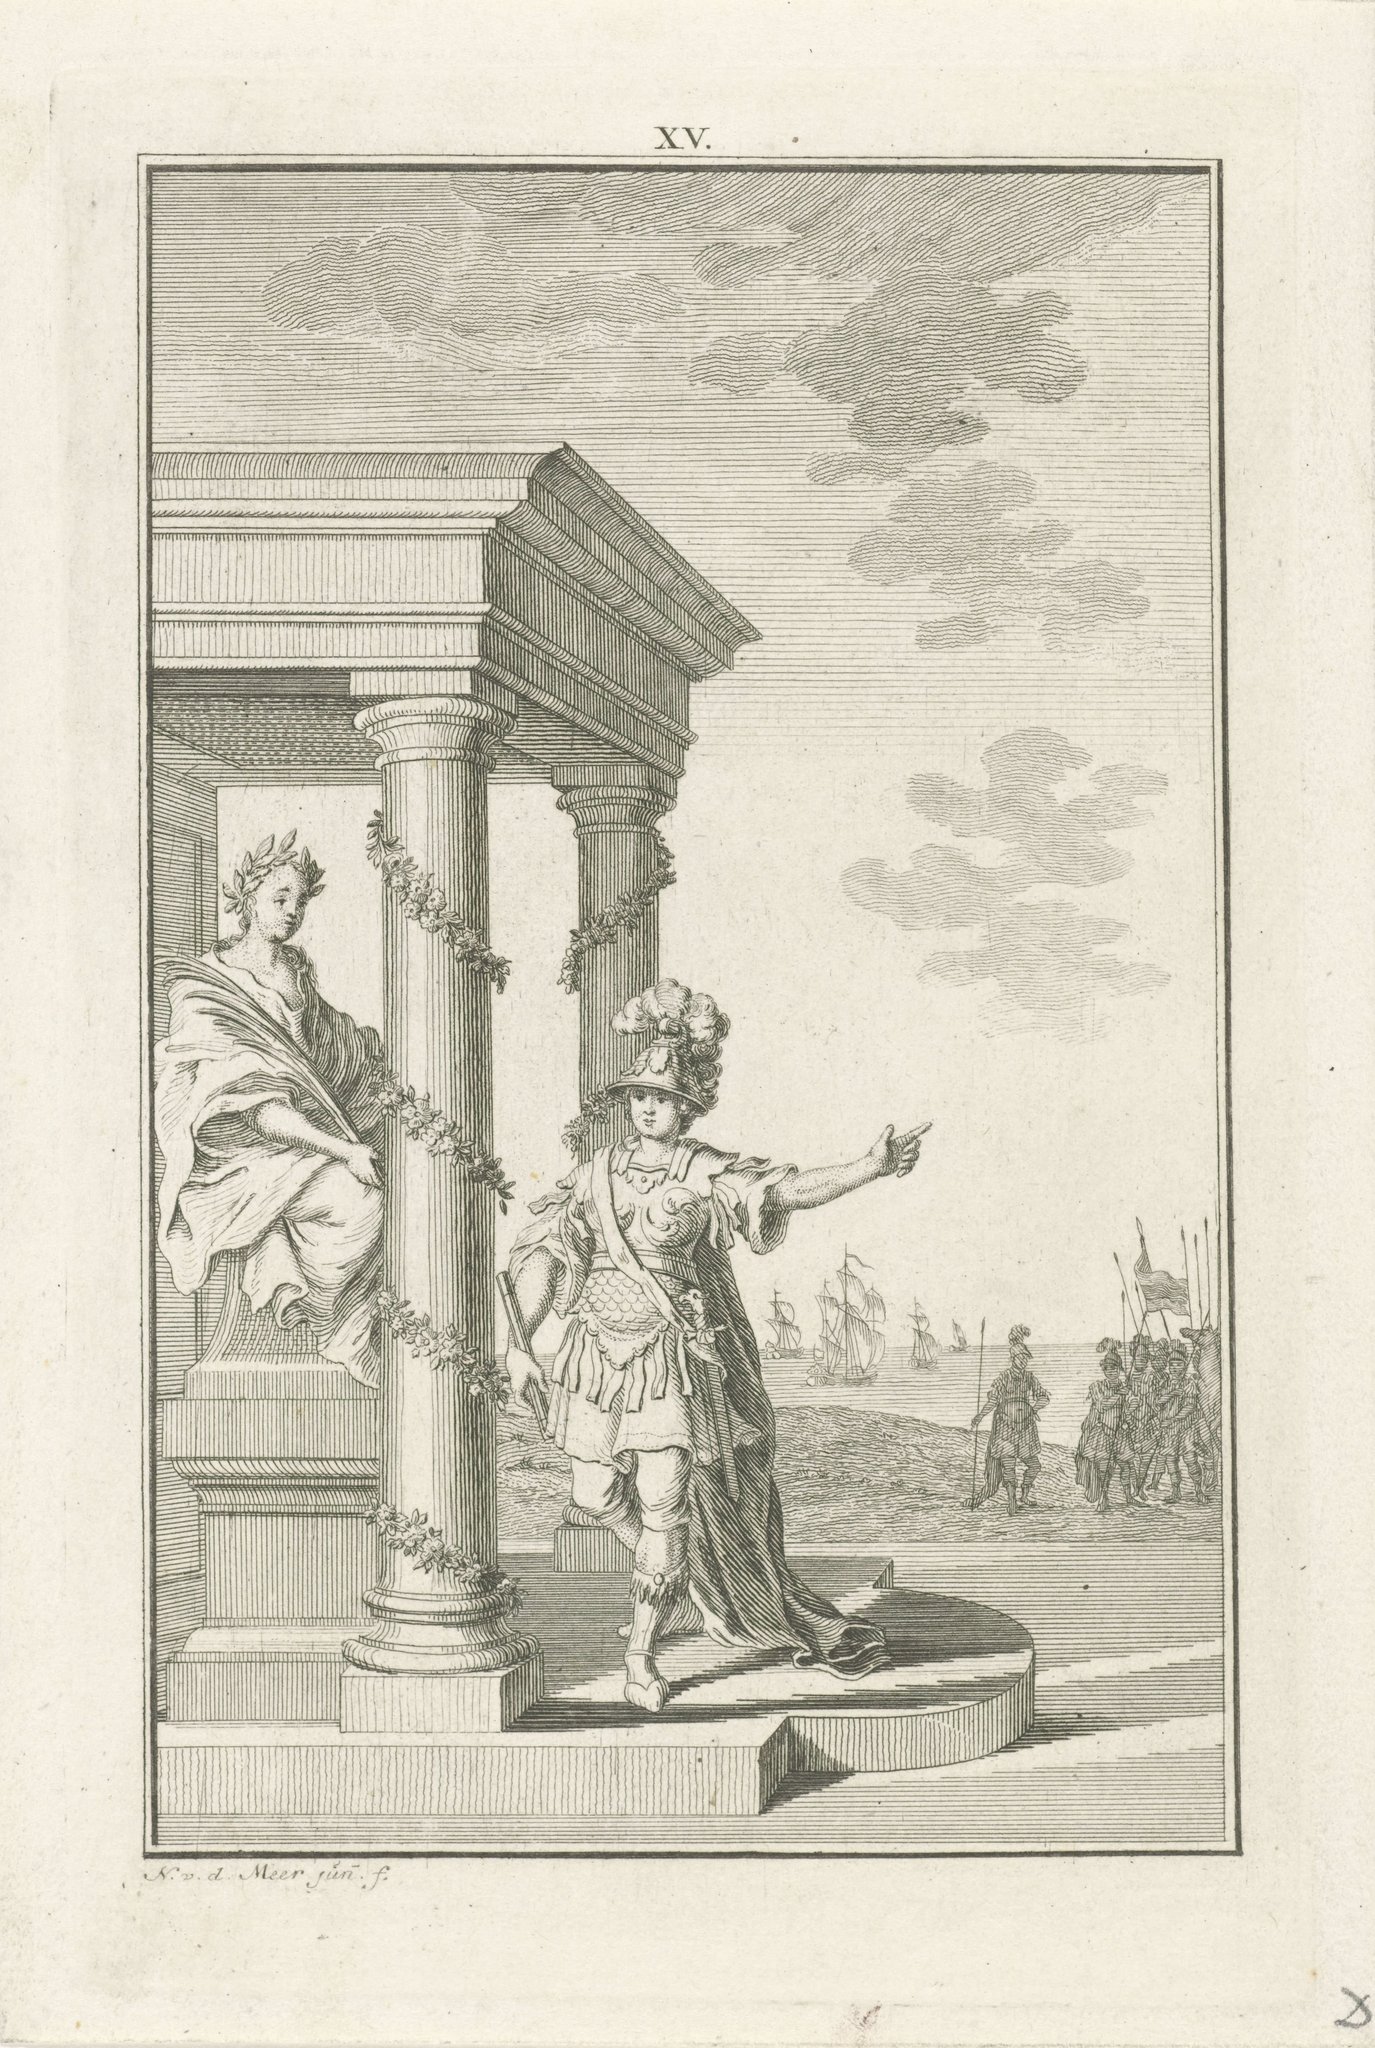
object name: print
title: Decoratie bij Albert van Goor in het Oudemanhuispoort te Amsterdam, 1766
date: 1776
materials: paper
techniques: etching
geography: leiden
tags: the hague, william v (prince of orange), symbols, allegories of peace, 'pax'; 'pace' (ripa), prince, throne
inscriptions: collector's mark: Lugt 2228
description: Decoratie aangebracht bij de kunstverlakker Albert van Goor in de Oudemanhuispoort te Amsterdam. Voorstelling van de prins als Romeinse held voor de Tempel van de Vrede. Ter gelegenheid van de meerderjarigheid van prins Willem V op 8 maart 1766. Genummerd bovenaan: XV.